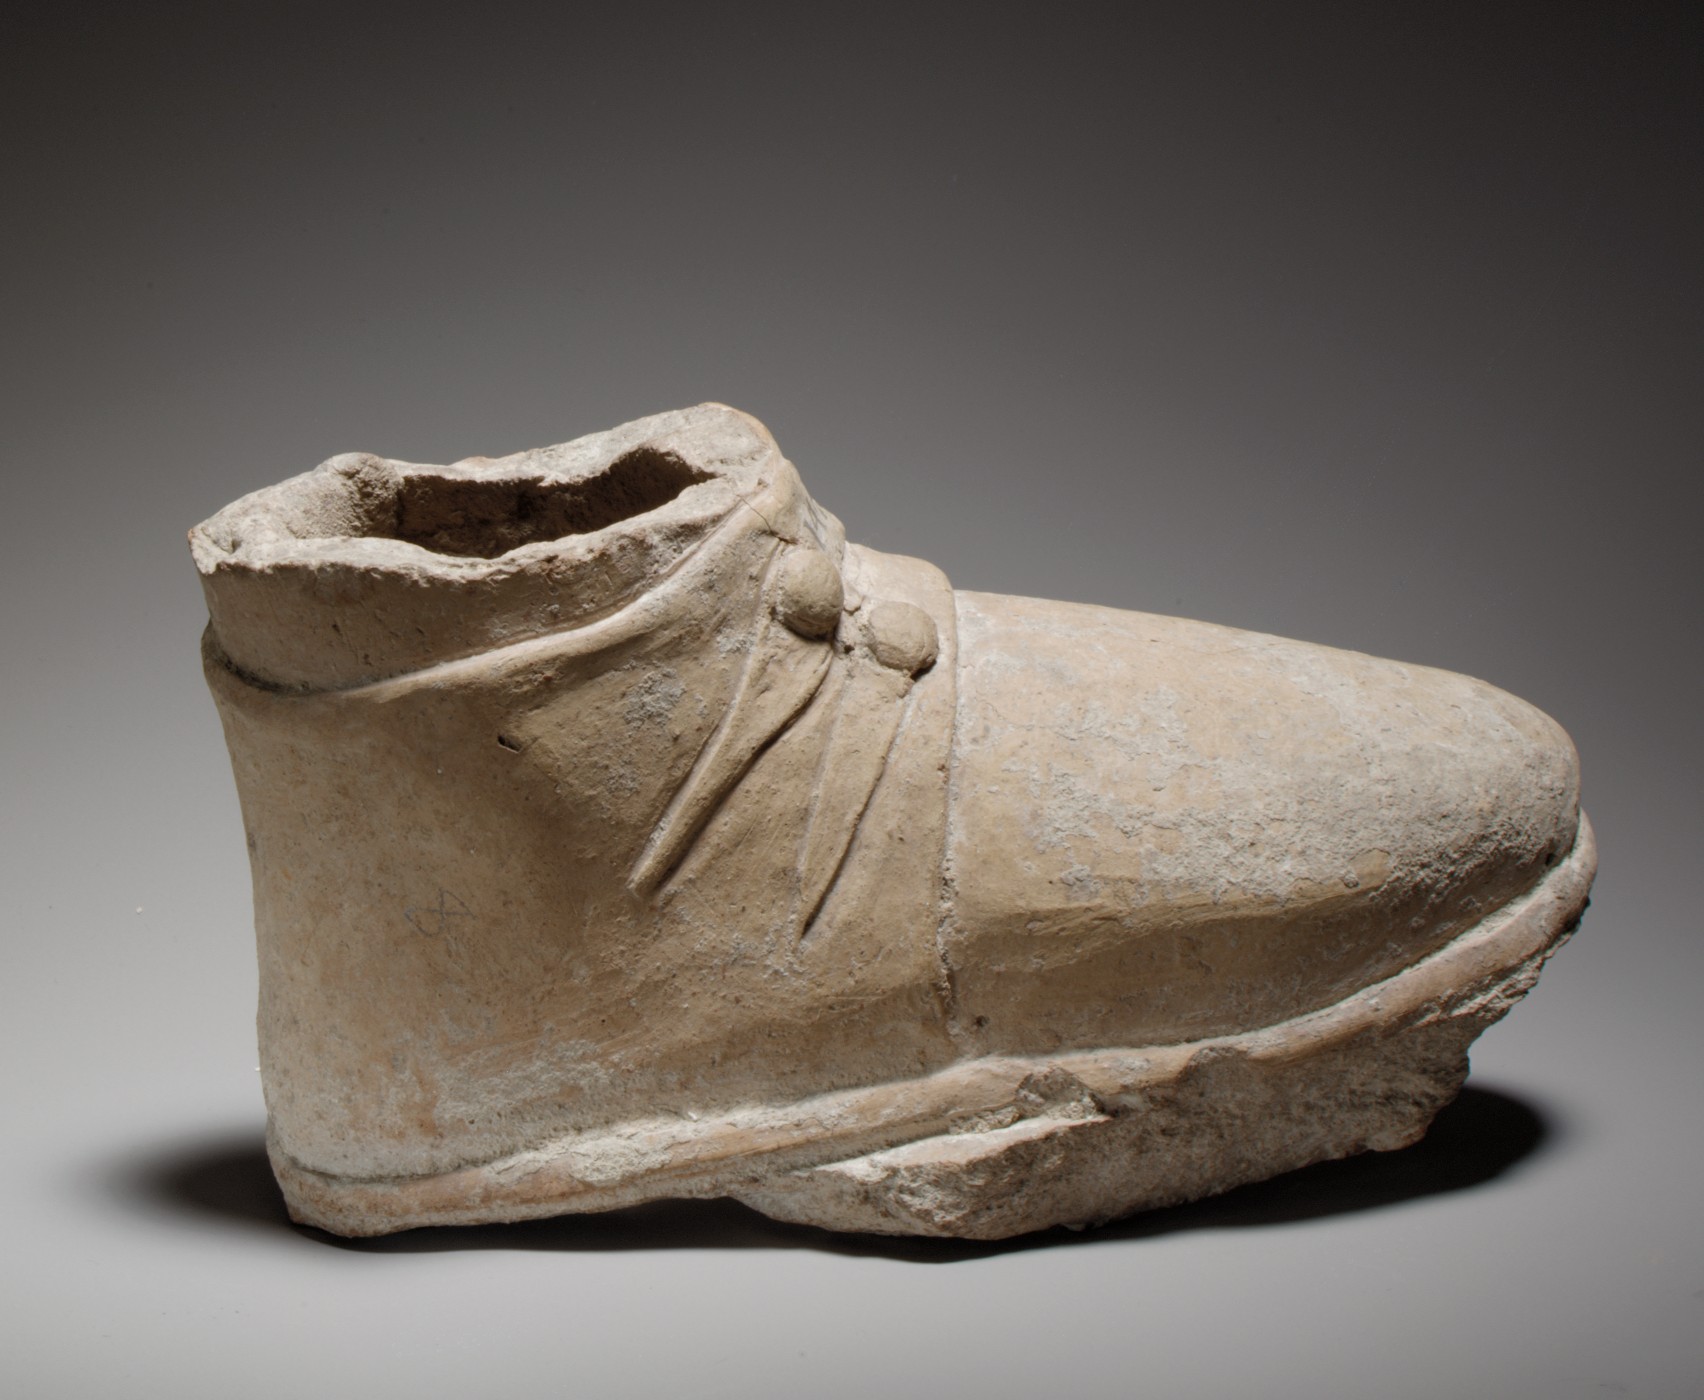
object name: foot with shoe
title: Right foot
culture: cypriot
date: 480-400 BCE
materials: terracotta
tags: shoes